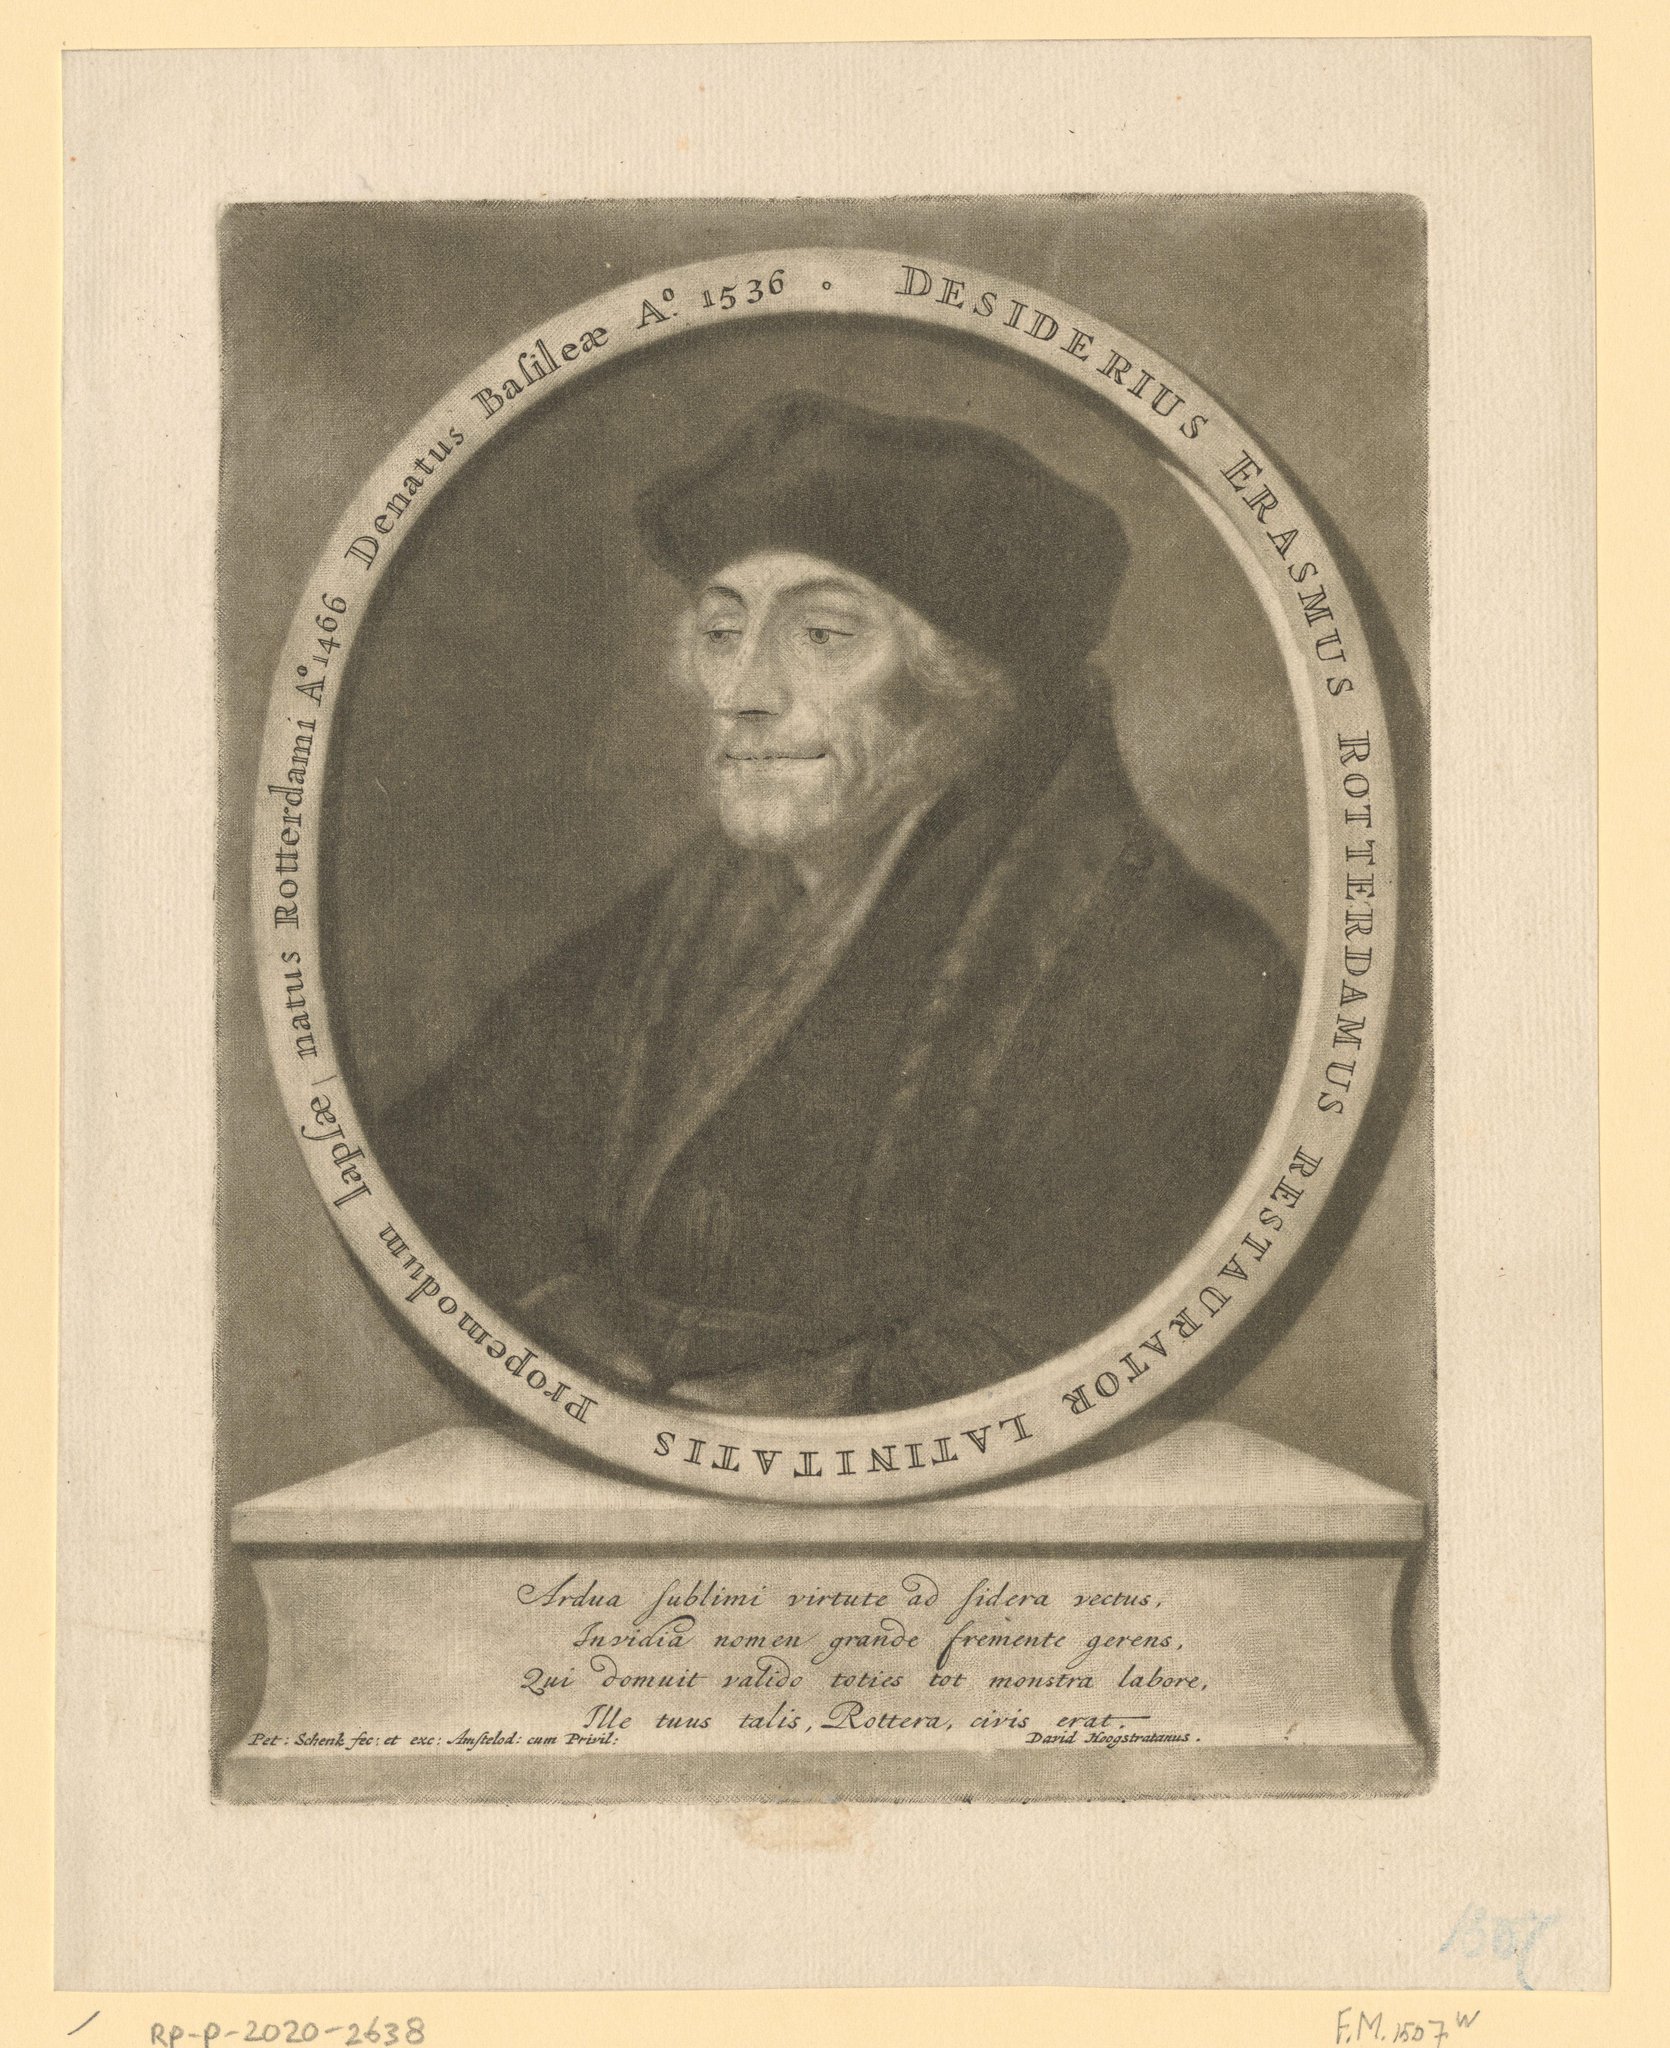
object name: print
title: Portret van Desiderius Erasmus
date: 1684-1711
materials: paper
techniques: engraving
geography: amsterdam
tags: desiderius erasmus, historical persons, scholar, philosopher (+ portrait of scholar, scientist)